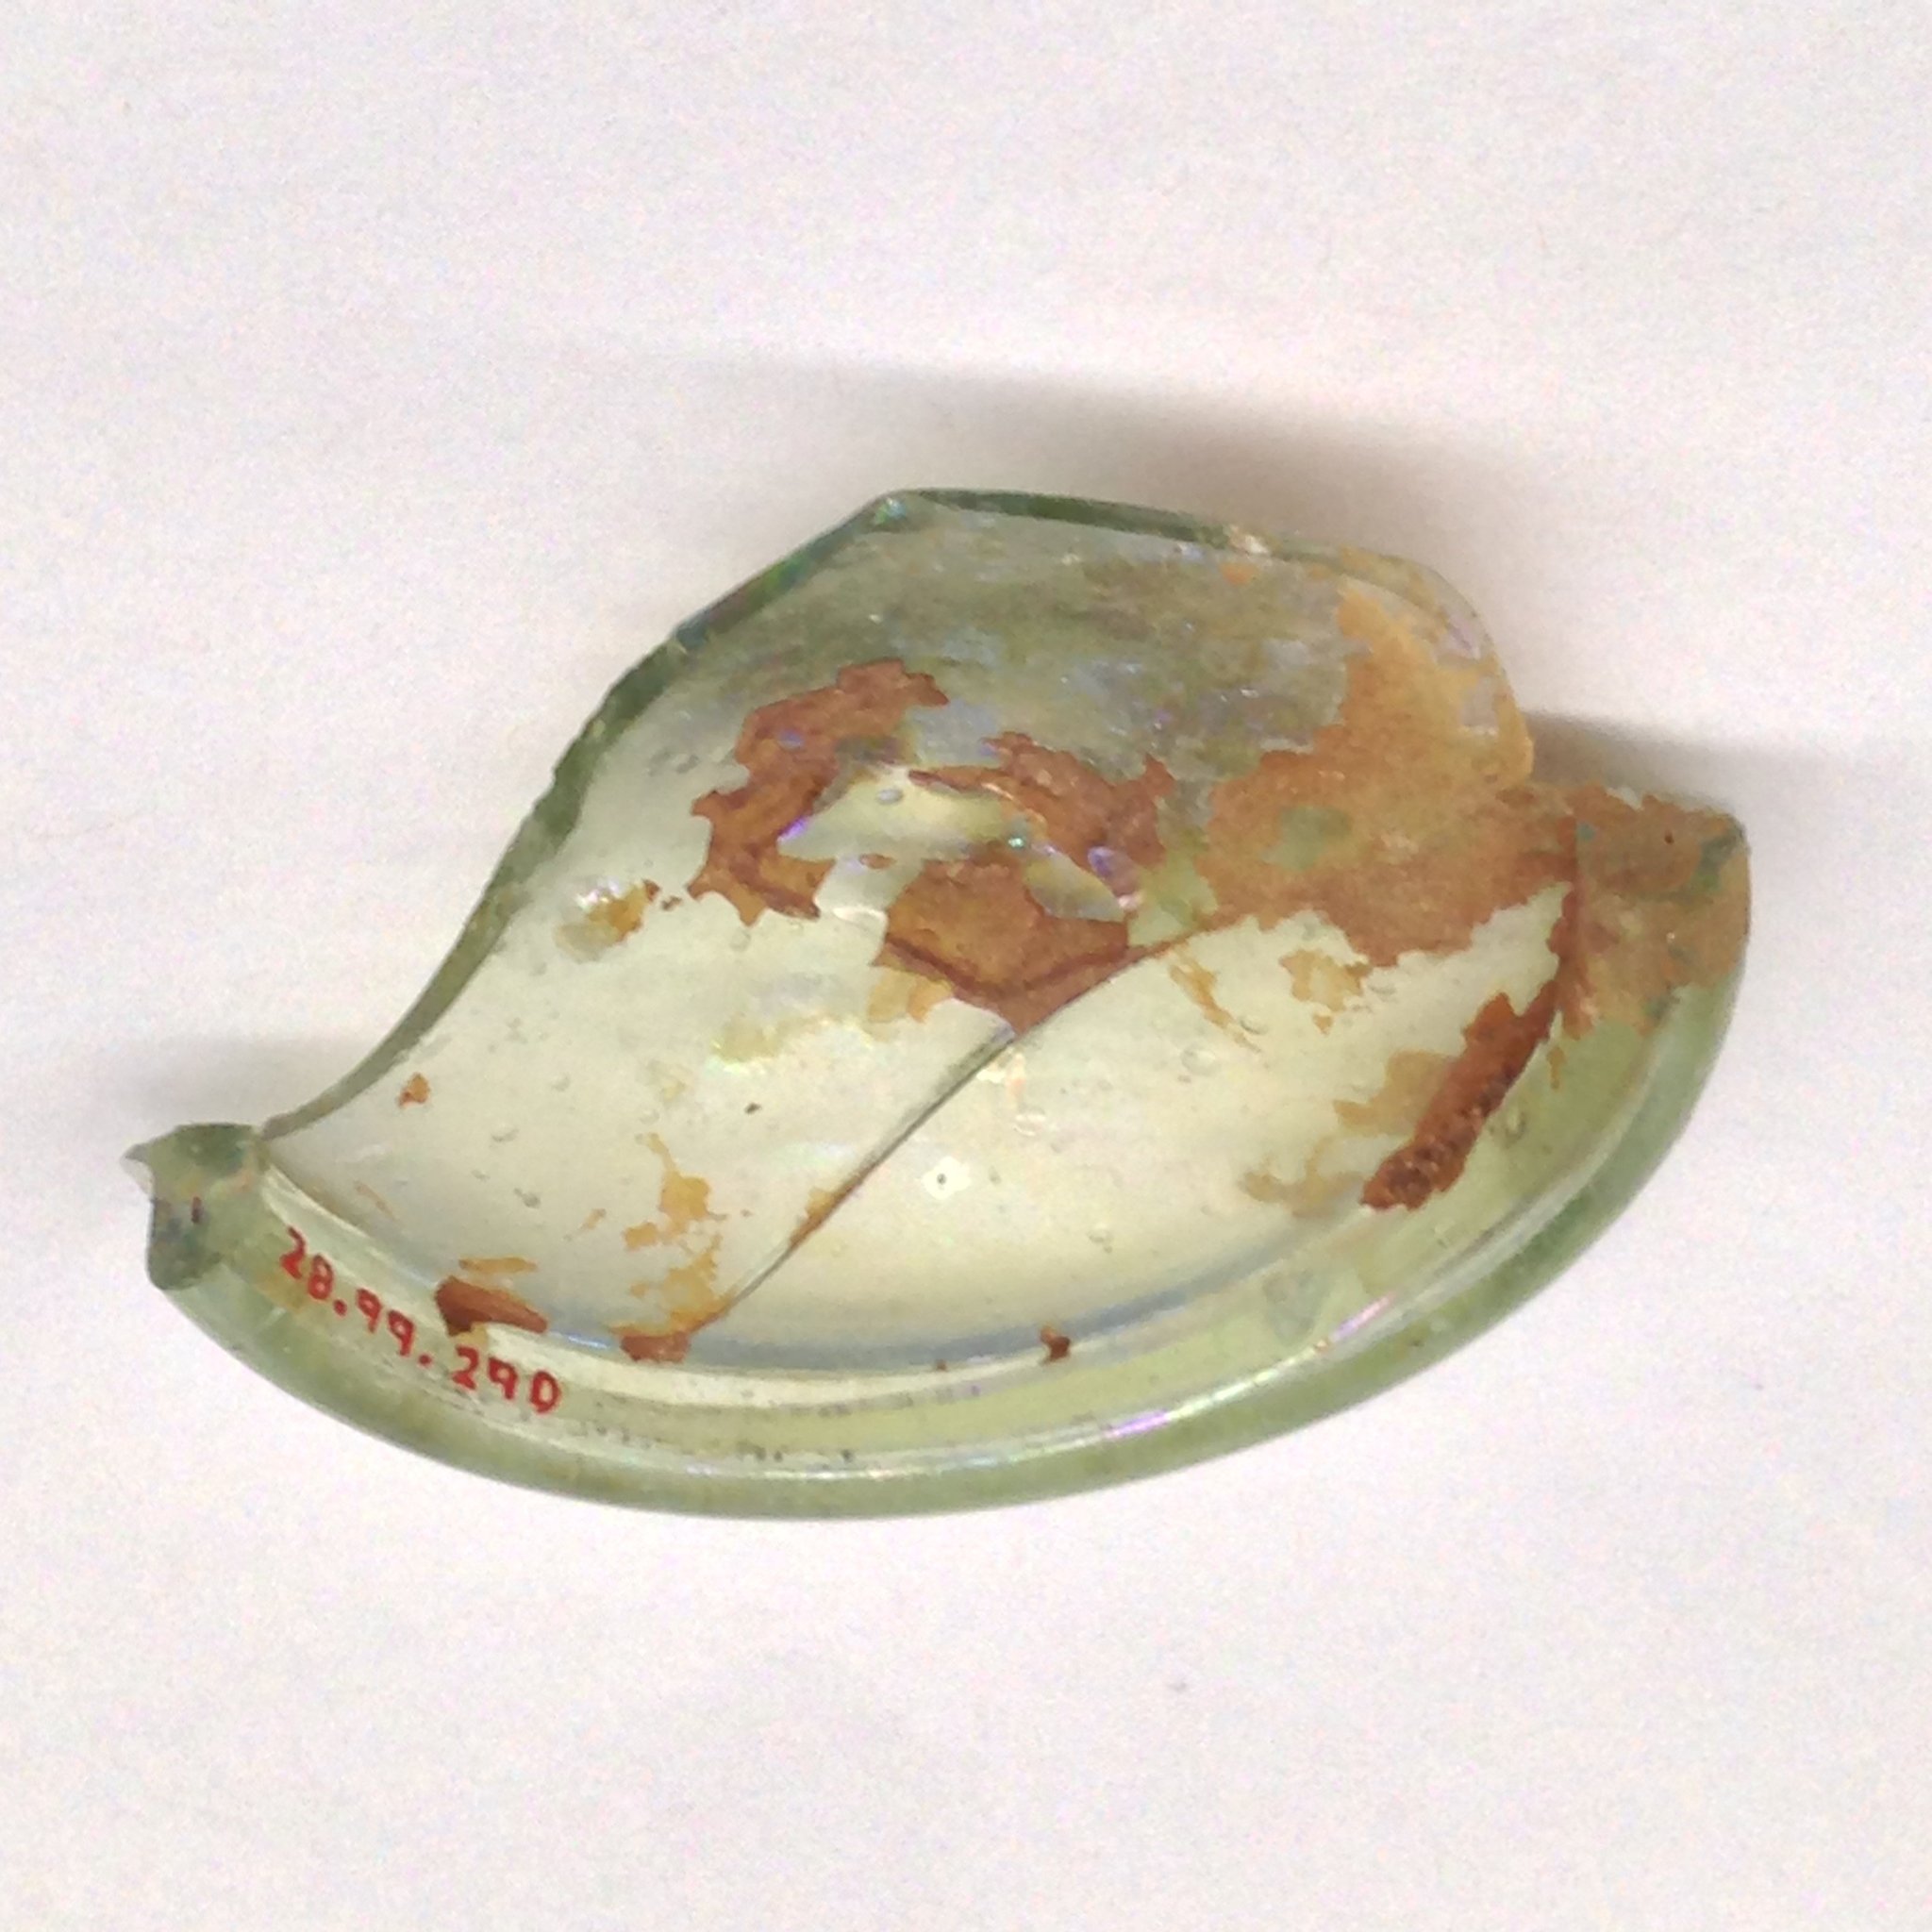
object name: fragment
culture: european or middle eastern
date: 1150-1250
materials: ceramic, glass